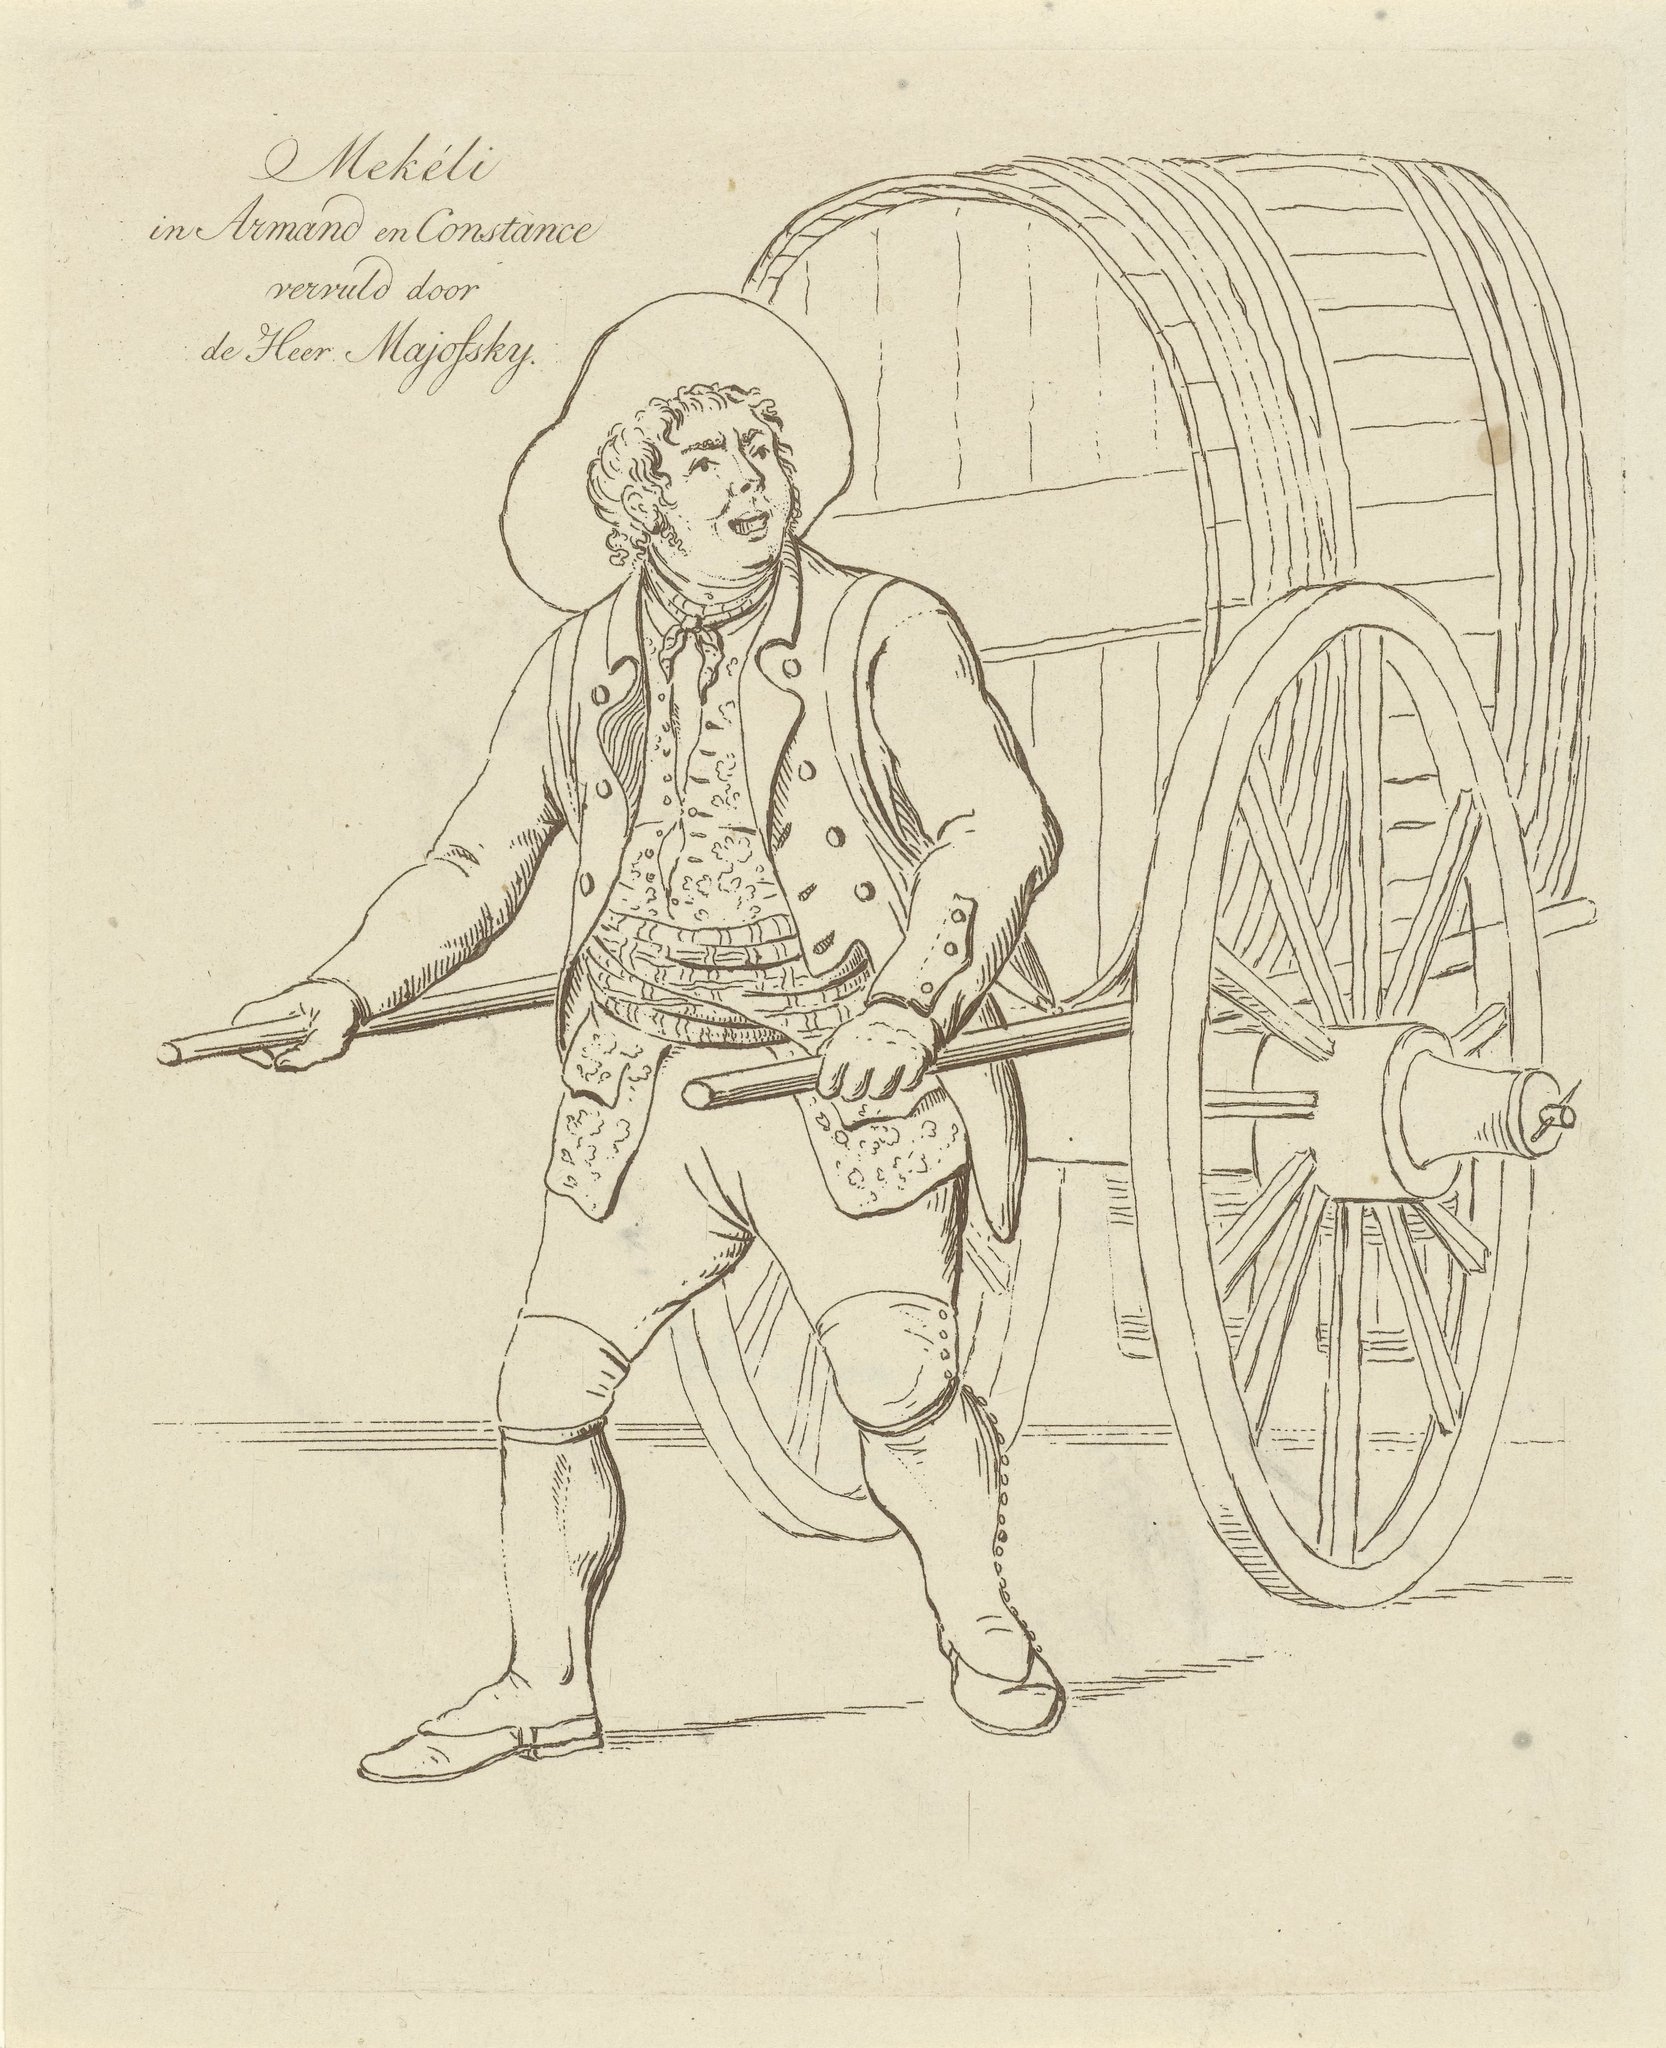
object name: print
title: Acteurs en actrices in verschillende rollen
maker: johannes jelgerhuis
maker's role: draughtsman, painter, print maker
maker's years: 1770-1836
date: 1805-1836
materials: paper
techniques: etching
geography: amsterdam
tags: actor (on the stage), historical persons (portraits and scenes from the life) (+ all kinds of 'portrait historié': mythological portrait, allegorical portrait, 'rollenporträt', etc.)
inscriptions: collector's mark: Lugt 2228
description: De acteur Theo Majofski als Mekéli, gekleed als landman een handkar trekkend. Prent uit een serie van tien met Nederlandse acteurs en actrices in verschillende rollen.